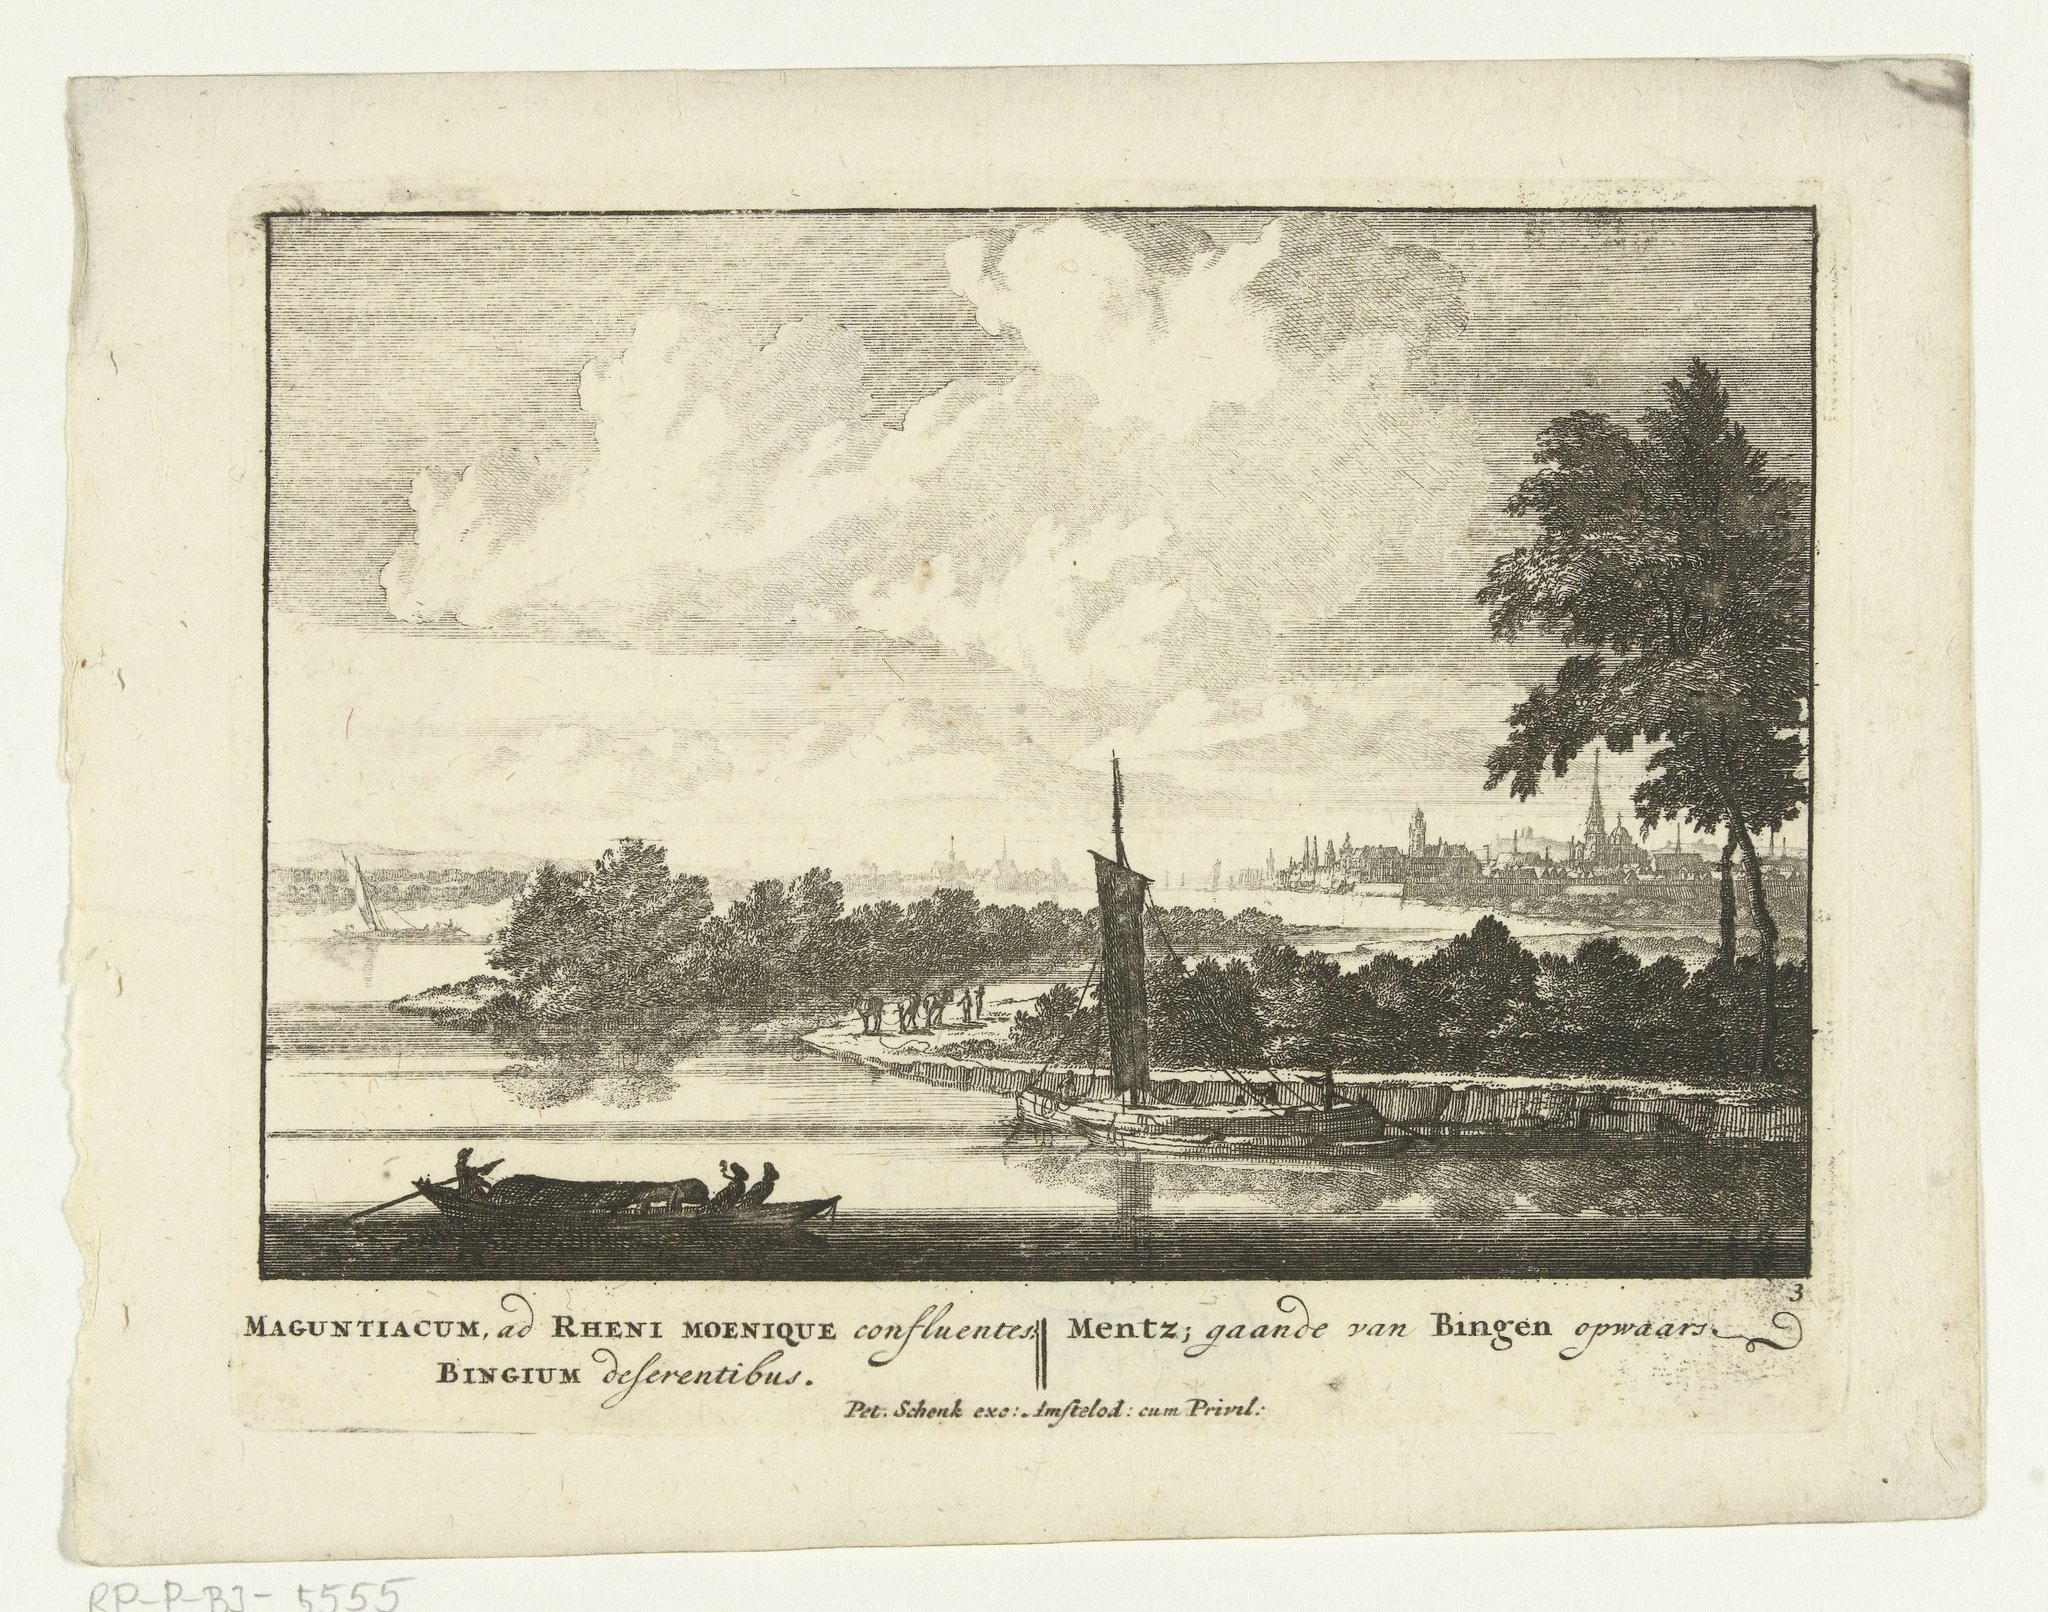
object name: print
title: Admirandorum quadruplex spectaculum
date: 1694-1697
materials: paper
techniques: etching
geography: amsterdam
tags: city-view in general; 'veduta', river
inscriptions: collector's mark: Lugt 2228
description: Prent uit een serie van 71 prenten met Rijnlandschappen, gezichten op vorstelijke paleizen en stadsgezichten uit Den Haag en Amsterdam.